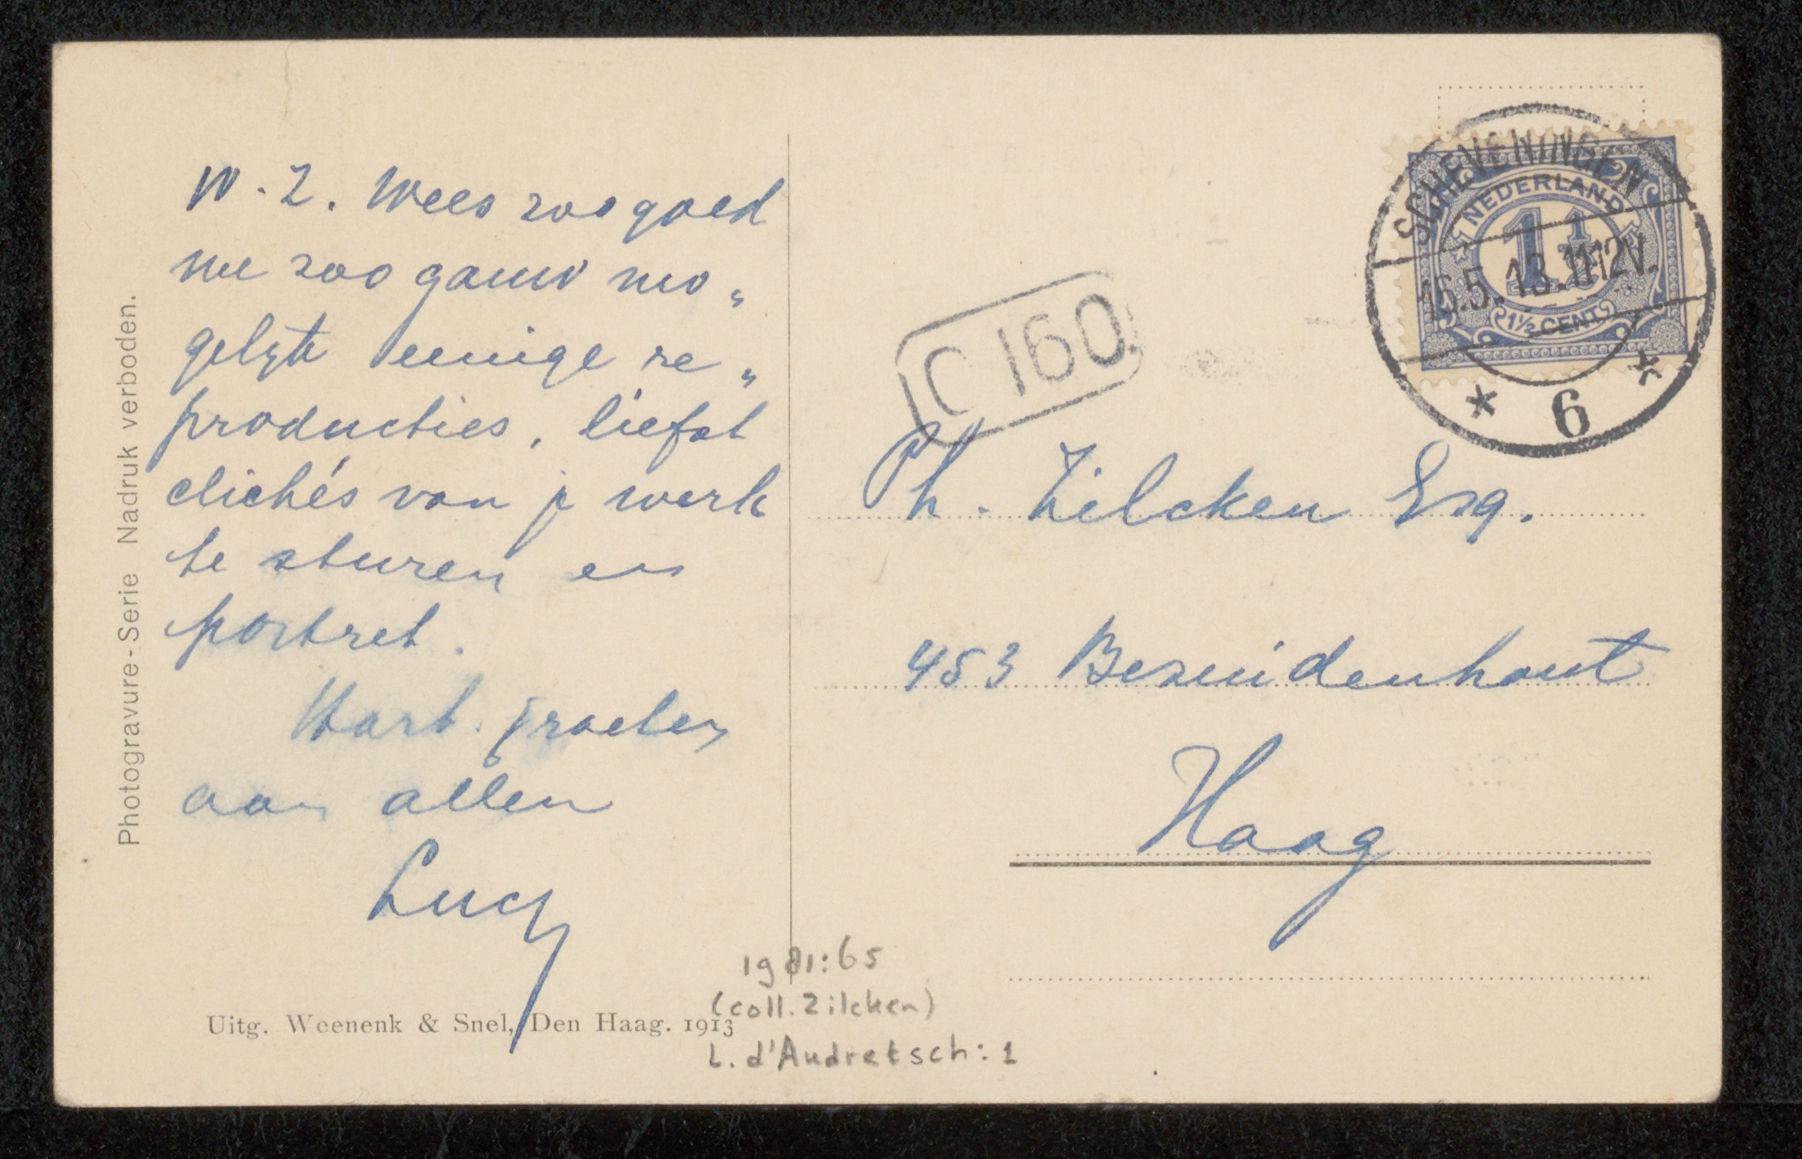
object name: ansichtkaart, prentbriefkaart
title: Prentbriefkaart aan Philip Zilcken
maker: lucy mary franssen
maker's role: auteur, letterkundige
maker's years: 1878-1959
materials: cardboard, ink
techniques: pen, printing, writing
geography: the hague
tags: painter, draughtsman, philip zilcken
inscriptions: collector's mark: ‘RPK’